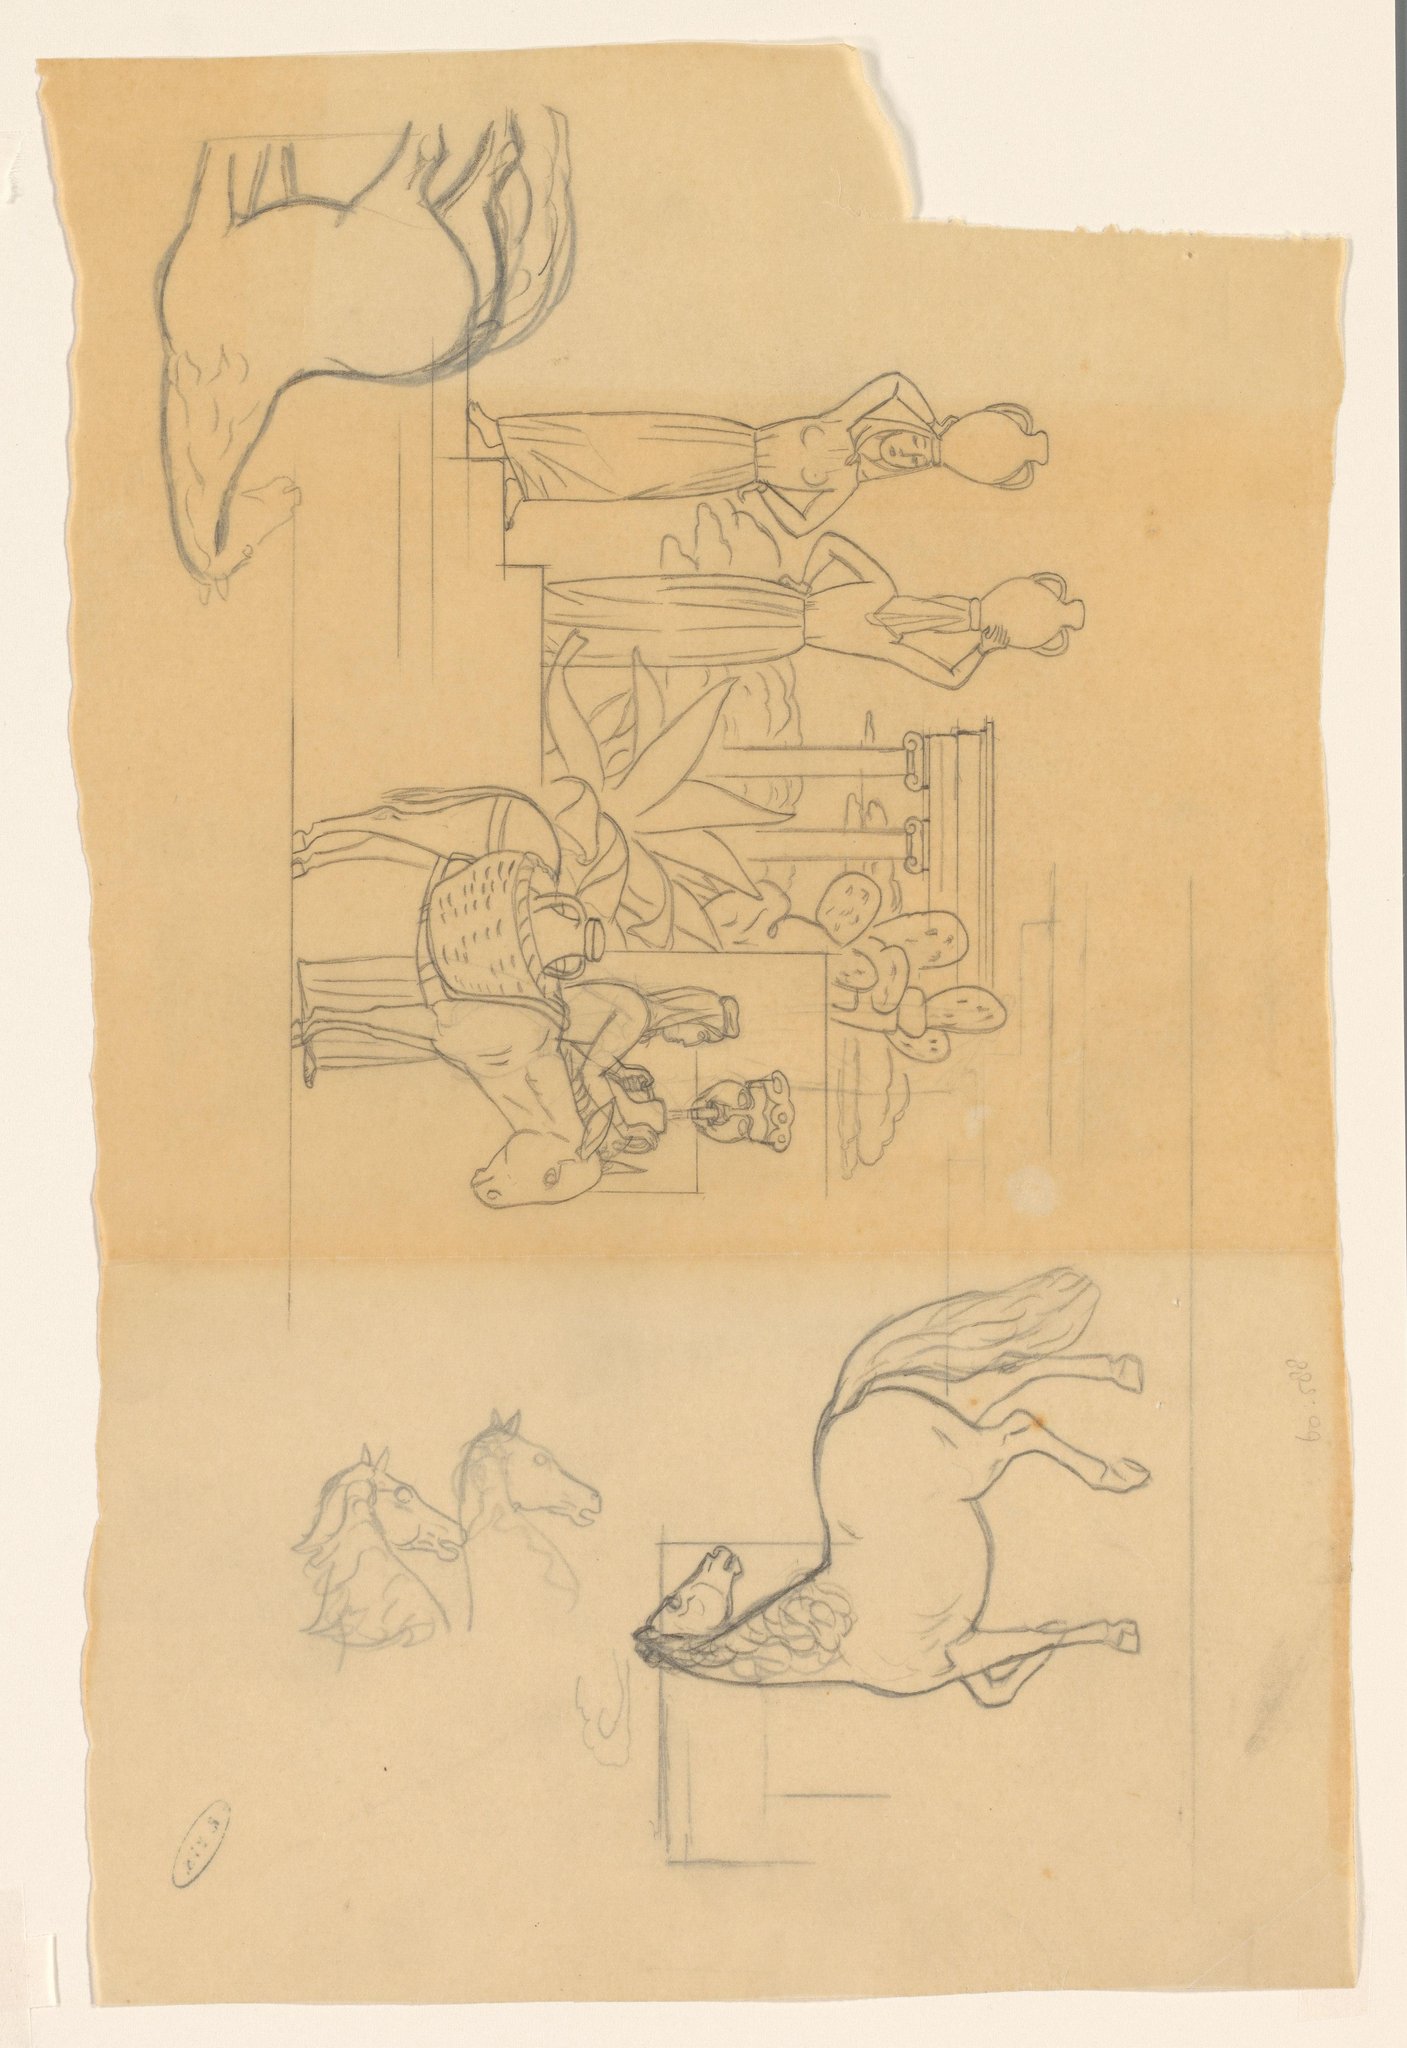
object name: drawing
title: Studieblad met vrouwen en een ezel bij een tempel en vier paarden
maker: leo gestel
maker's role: draughtsman, print maker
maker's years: 1881-1941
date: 1891-1941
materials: pencil, paper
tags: ass, donkey, female sex; woman, temple, shrine ~ non-christian religions, container of ceramics: jar, jug, pot, vase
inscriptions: collector's mark: Lugt 2228